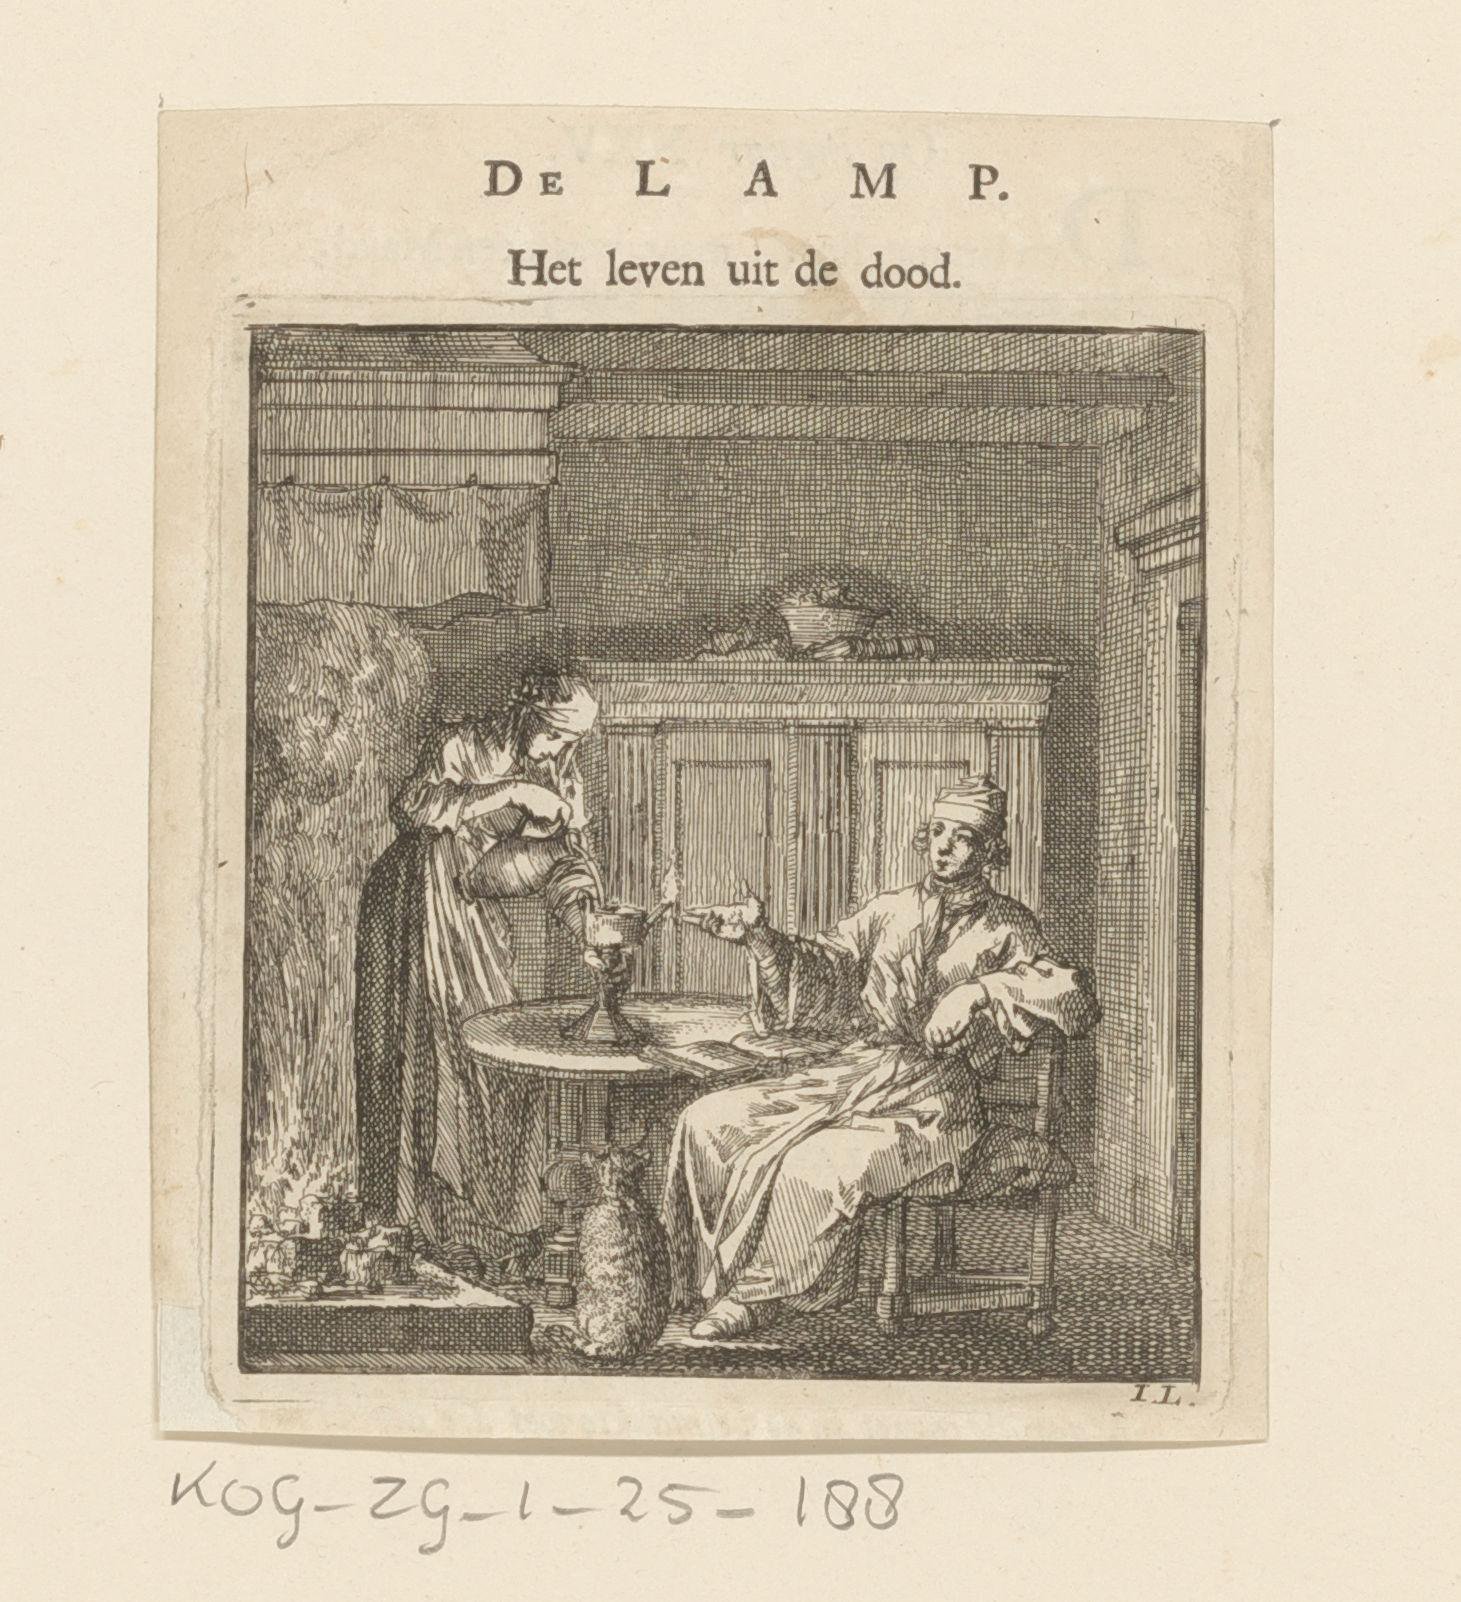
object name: book illustration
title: De Lamp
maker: jan luyken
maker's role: draughtsman, print maker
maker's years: 1649-1712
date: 1711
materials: paper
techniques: etching, letterpress printing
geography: amsterdam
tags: cat, oil-lamp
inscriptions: stamp, collector's mark: Lugt 1641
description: Prent uit: Luyken, Jan. Het leerzaam huisraad, vertoond in vyftig konstige figuuren, met godlyke spreuken en stichtelyke verzen. Amsterdam: weduwe Pieter Arentsz. II en Cornelis van der Sys, 1711, p. 90.